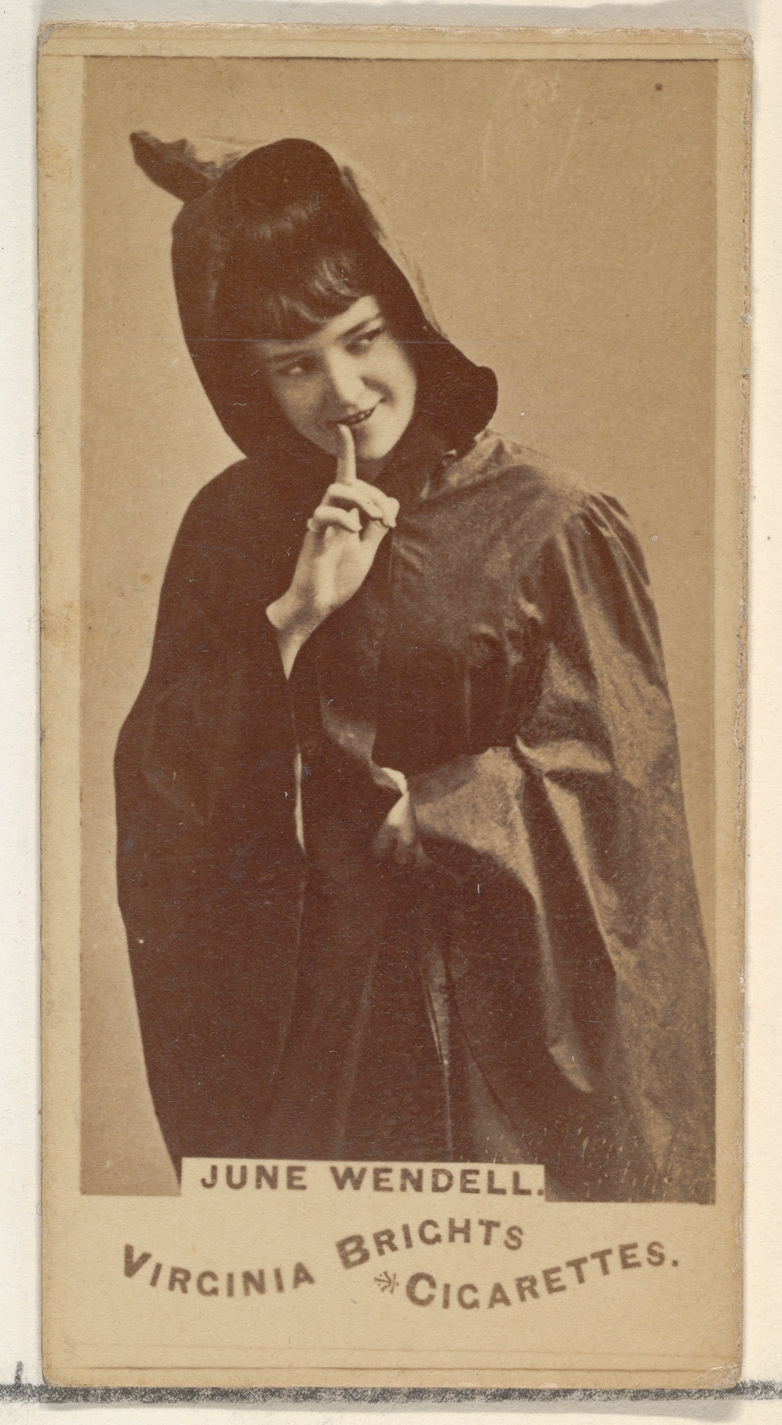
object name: photograph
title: June Wendell, from the Actors and Actresses series (N45, Type 1) for Virginia Brights Cigarettes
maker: allen & ginter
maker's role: publisher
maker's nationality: american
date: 1888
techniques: albumen silver print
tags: portraits,women,actresses